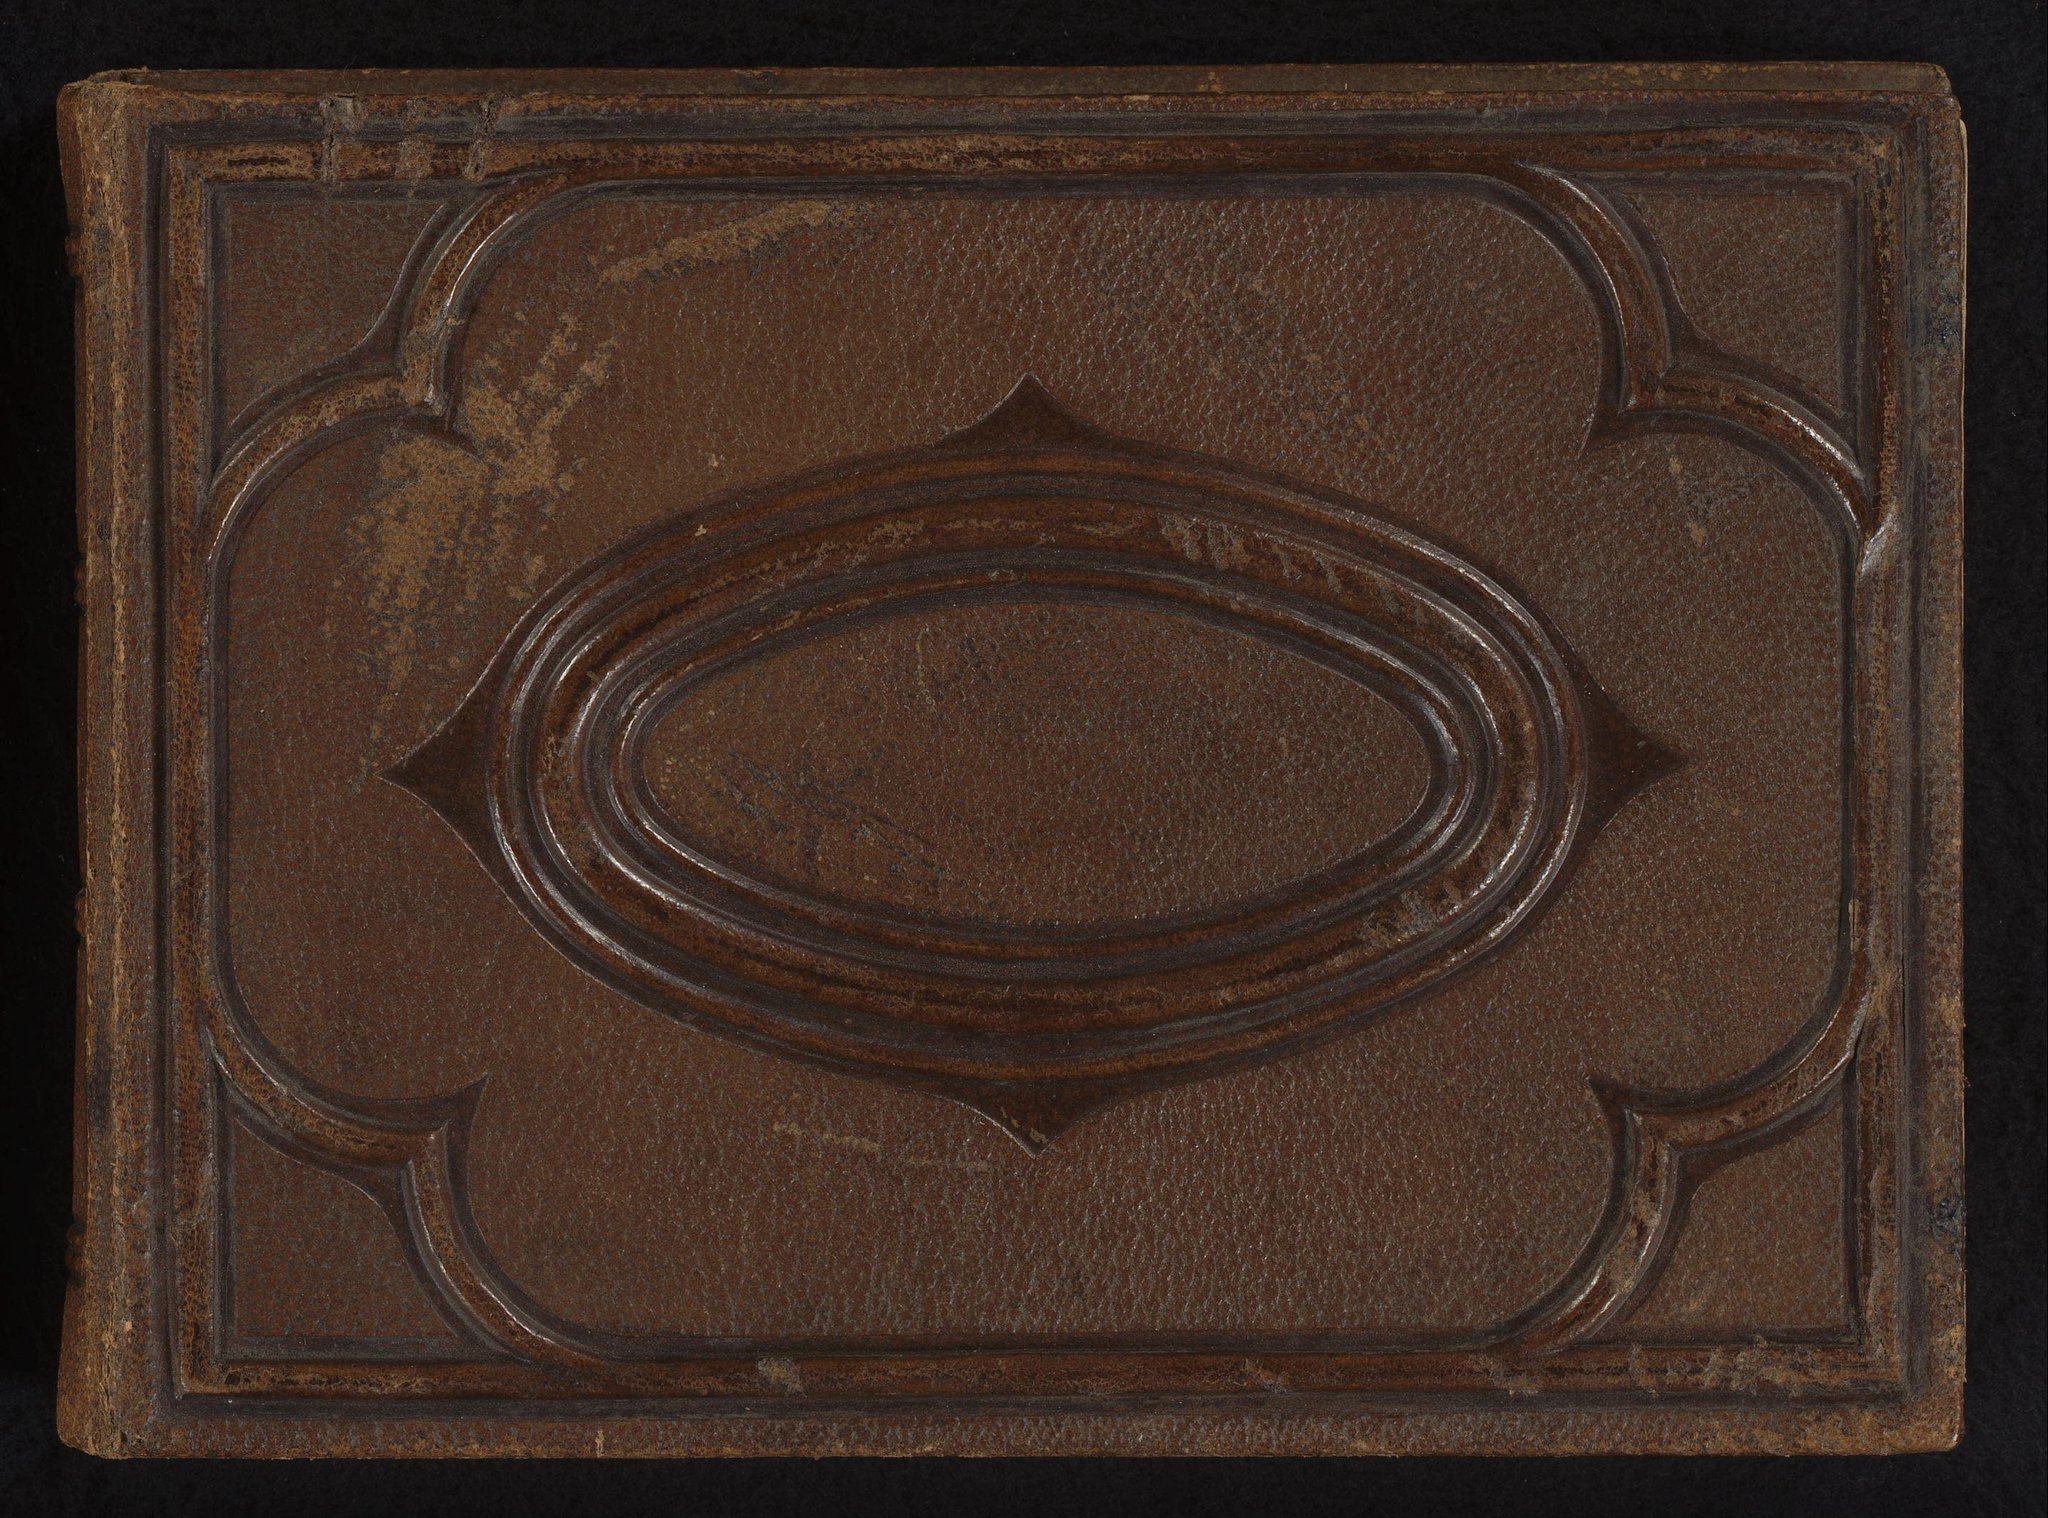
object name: photograph album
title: Frans album met 41 foto's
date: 1859-1900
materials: cardboard, celluloid, leather, photographic support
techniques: albumen print, hand coloring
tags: city-view in general; 'veduta', historical persons, church (exterior), painting, drawing and the graphic arts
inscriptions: inscription: ‘Dienst/ Verspreide/ Rijkskollekties/ (...)’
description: Fotoalbum met 30 pagina's met in totaal 41 foto's, alle cartes-de-visite. Het album bevat portretten, maar ook fotoreproducties van topografische prenten of portretten, ook bevat het album stadsgezichten van verschillende plaatsen in Frankrijk, waaronder Nimes, Saite-Anne d'Auray en Nantes.